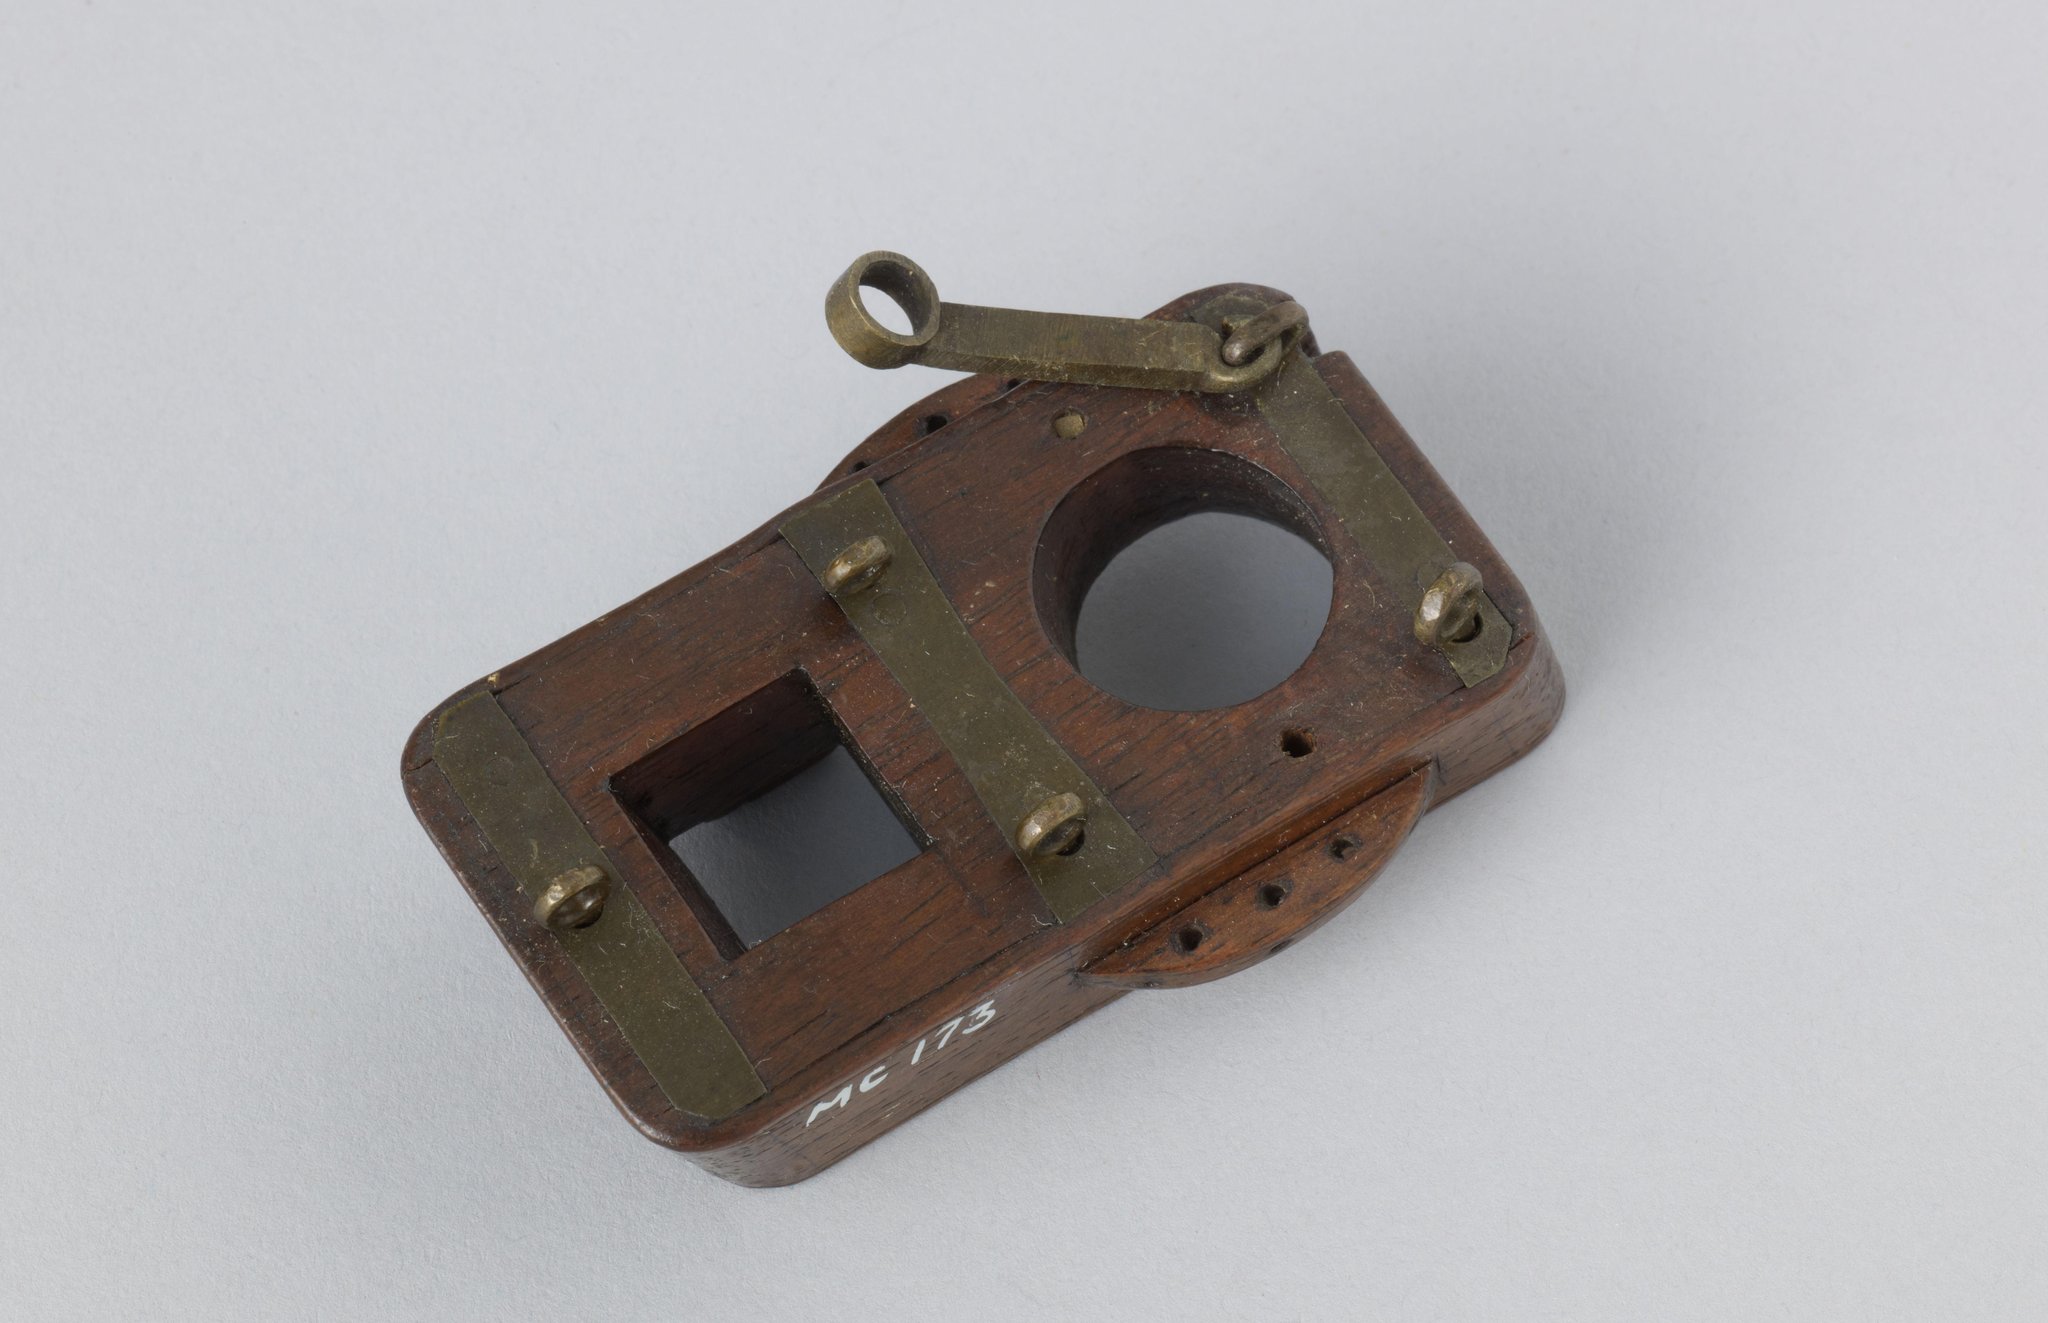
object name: demonstration model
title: Model of a Bowsprit Cap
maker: Anonymous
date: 1780-1840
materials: brass, wood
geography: netherlands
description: Rechthoekig schild met beugels voor de geusstok; aan de achterkant zijn ogen voor de loopstagen en ander stagen en een blok aangebracht. Tegen de zijden zitten twee oren met gaten voor het lopend want van het kluifhout.